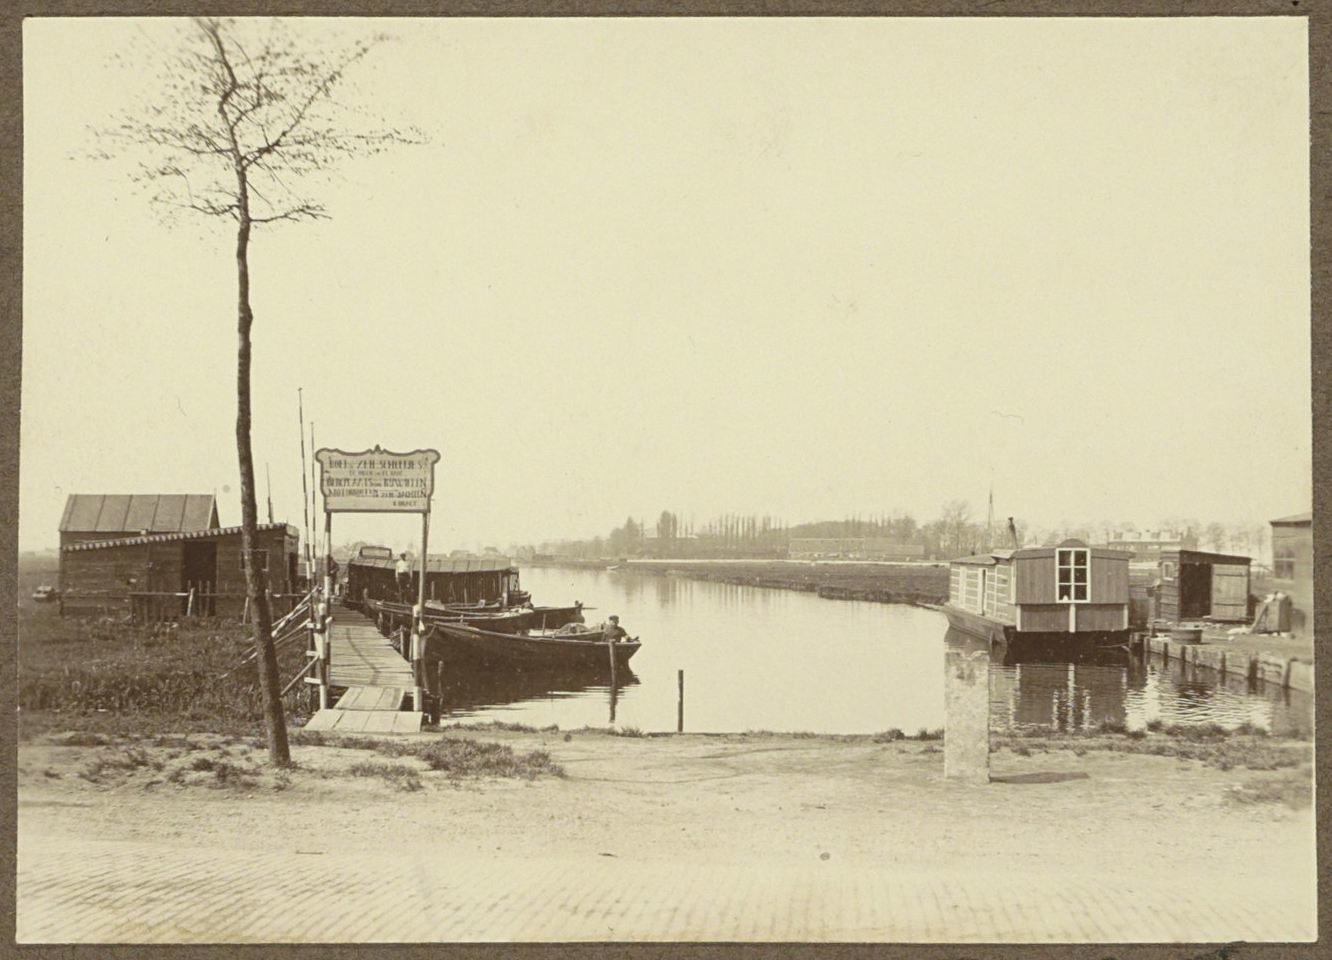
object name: photograph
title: Haven aan de Amstelveenseweg met links een verhuurinrichting voor boten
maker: Anonymous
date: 1910-1930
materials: paper, photographic support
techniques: daylight paper print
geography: north holland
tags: harbour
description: Onderdeel van Album met foto's van Amsterdam en omgeving.